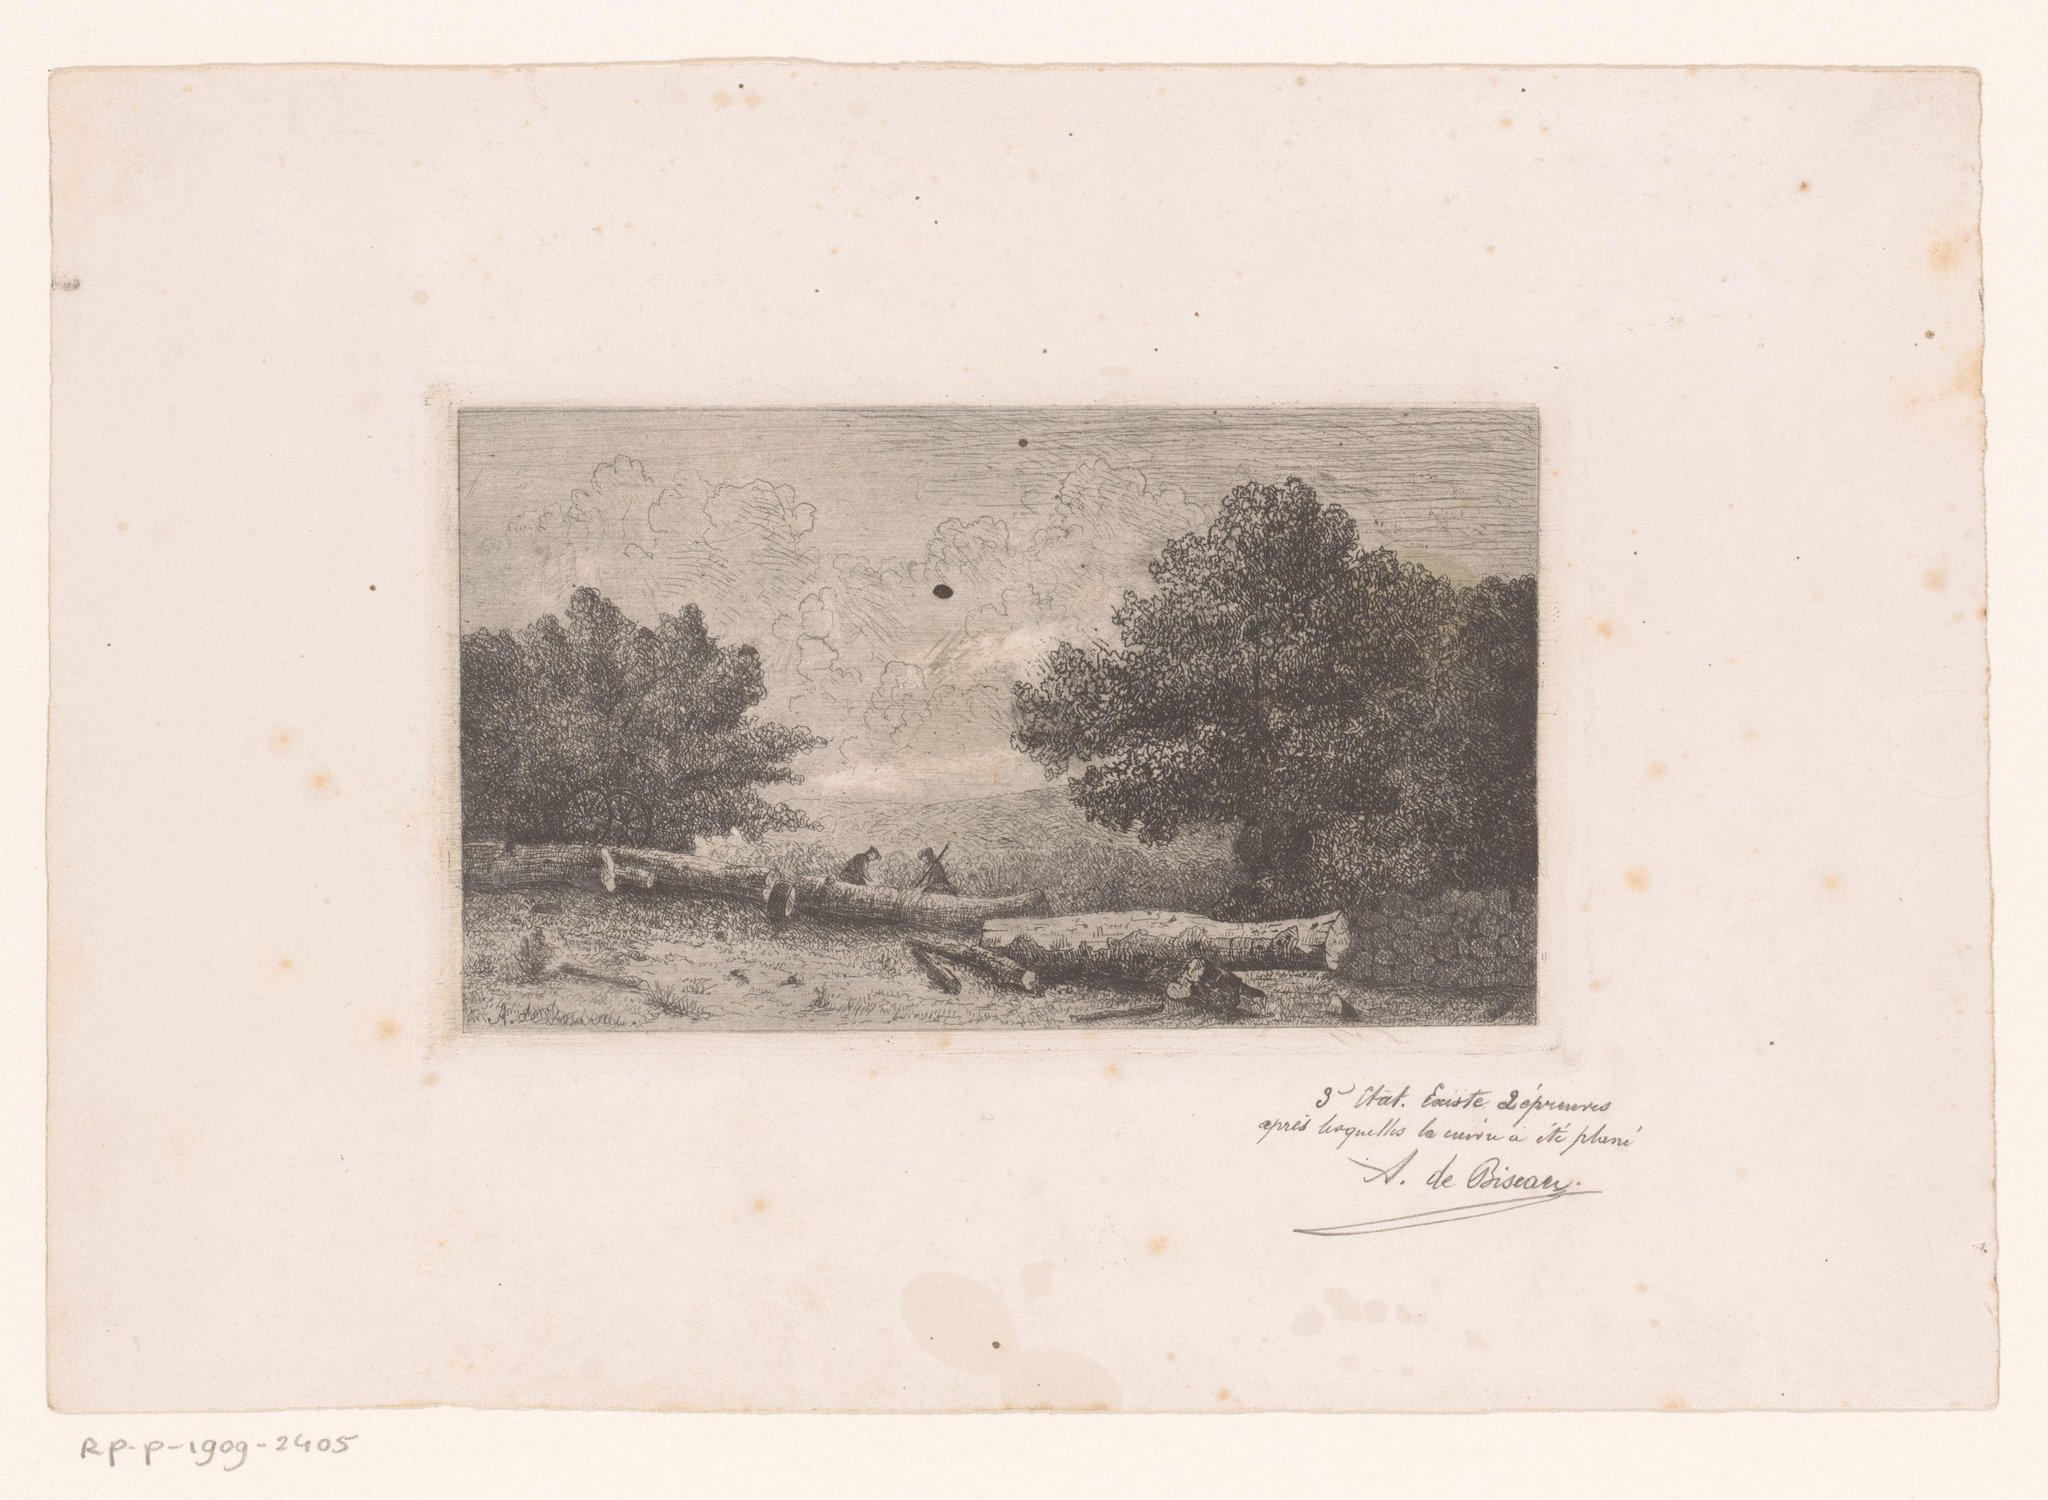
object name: print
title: Landschap met twee houthakkers die een boomstam doorzagen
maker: aristide de biseau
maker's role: print maker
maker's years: 1844-1883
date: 1854-1883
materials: paper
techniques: etching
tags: landscapes, woodcutting, woodcutter ~ forestry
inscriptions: inscription: ‘3e Etat Existe Epreuves après [...] été plané’, collector's mark: Lugt 2228